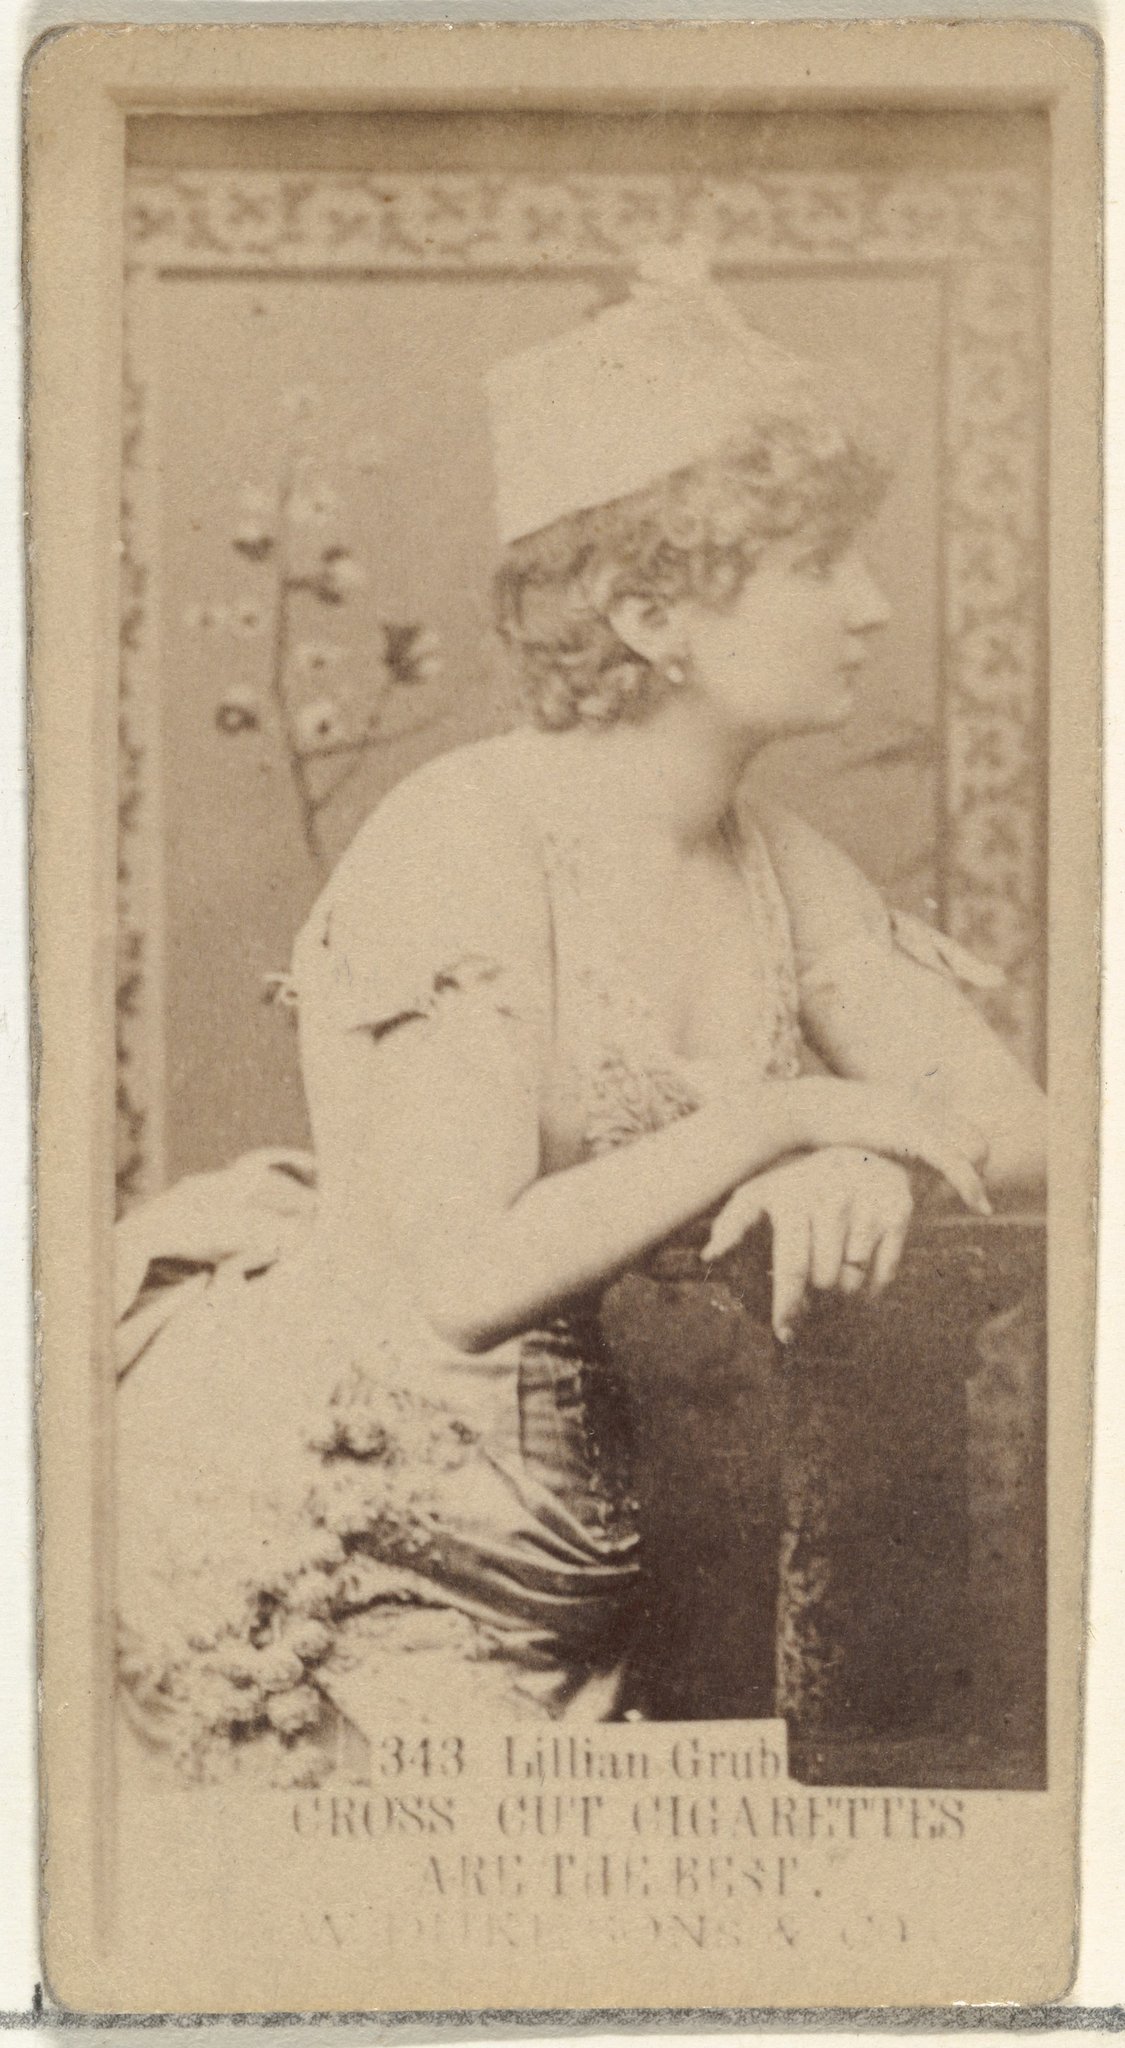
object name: photograph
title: Card Number 343, Lillian Grubb, from the Actors and Actresses series (N145-3) issued by Duke Sons & Co. to promote Cross Cut Cigarettes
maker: w. duke, sons & co.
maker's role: publisher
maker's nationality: american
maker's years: 1870-1920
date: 1880-1889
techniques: albumen silver print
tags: women,actresses